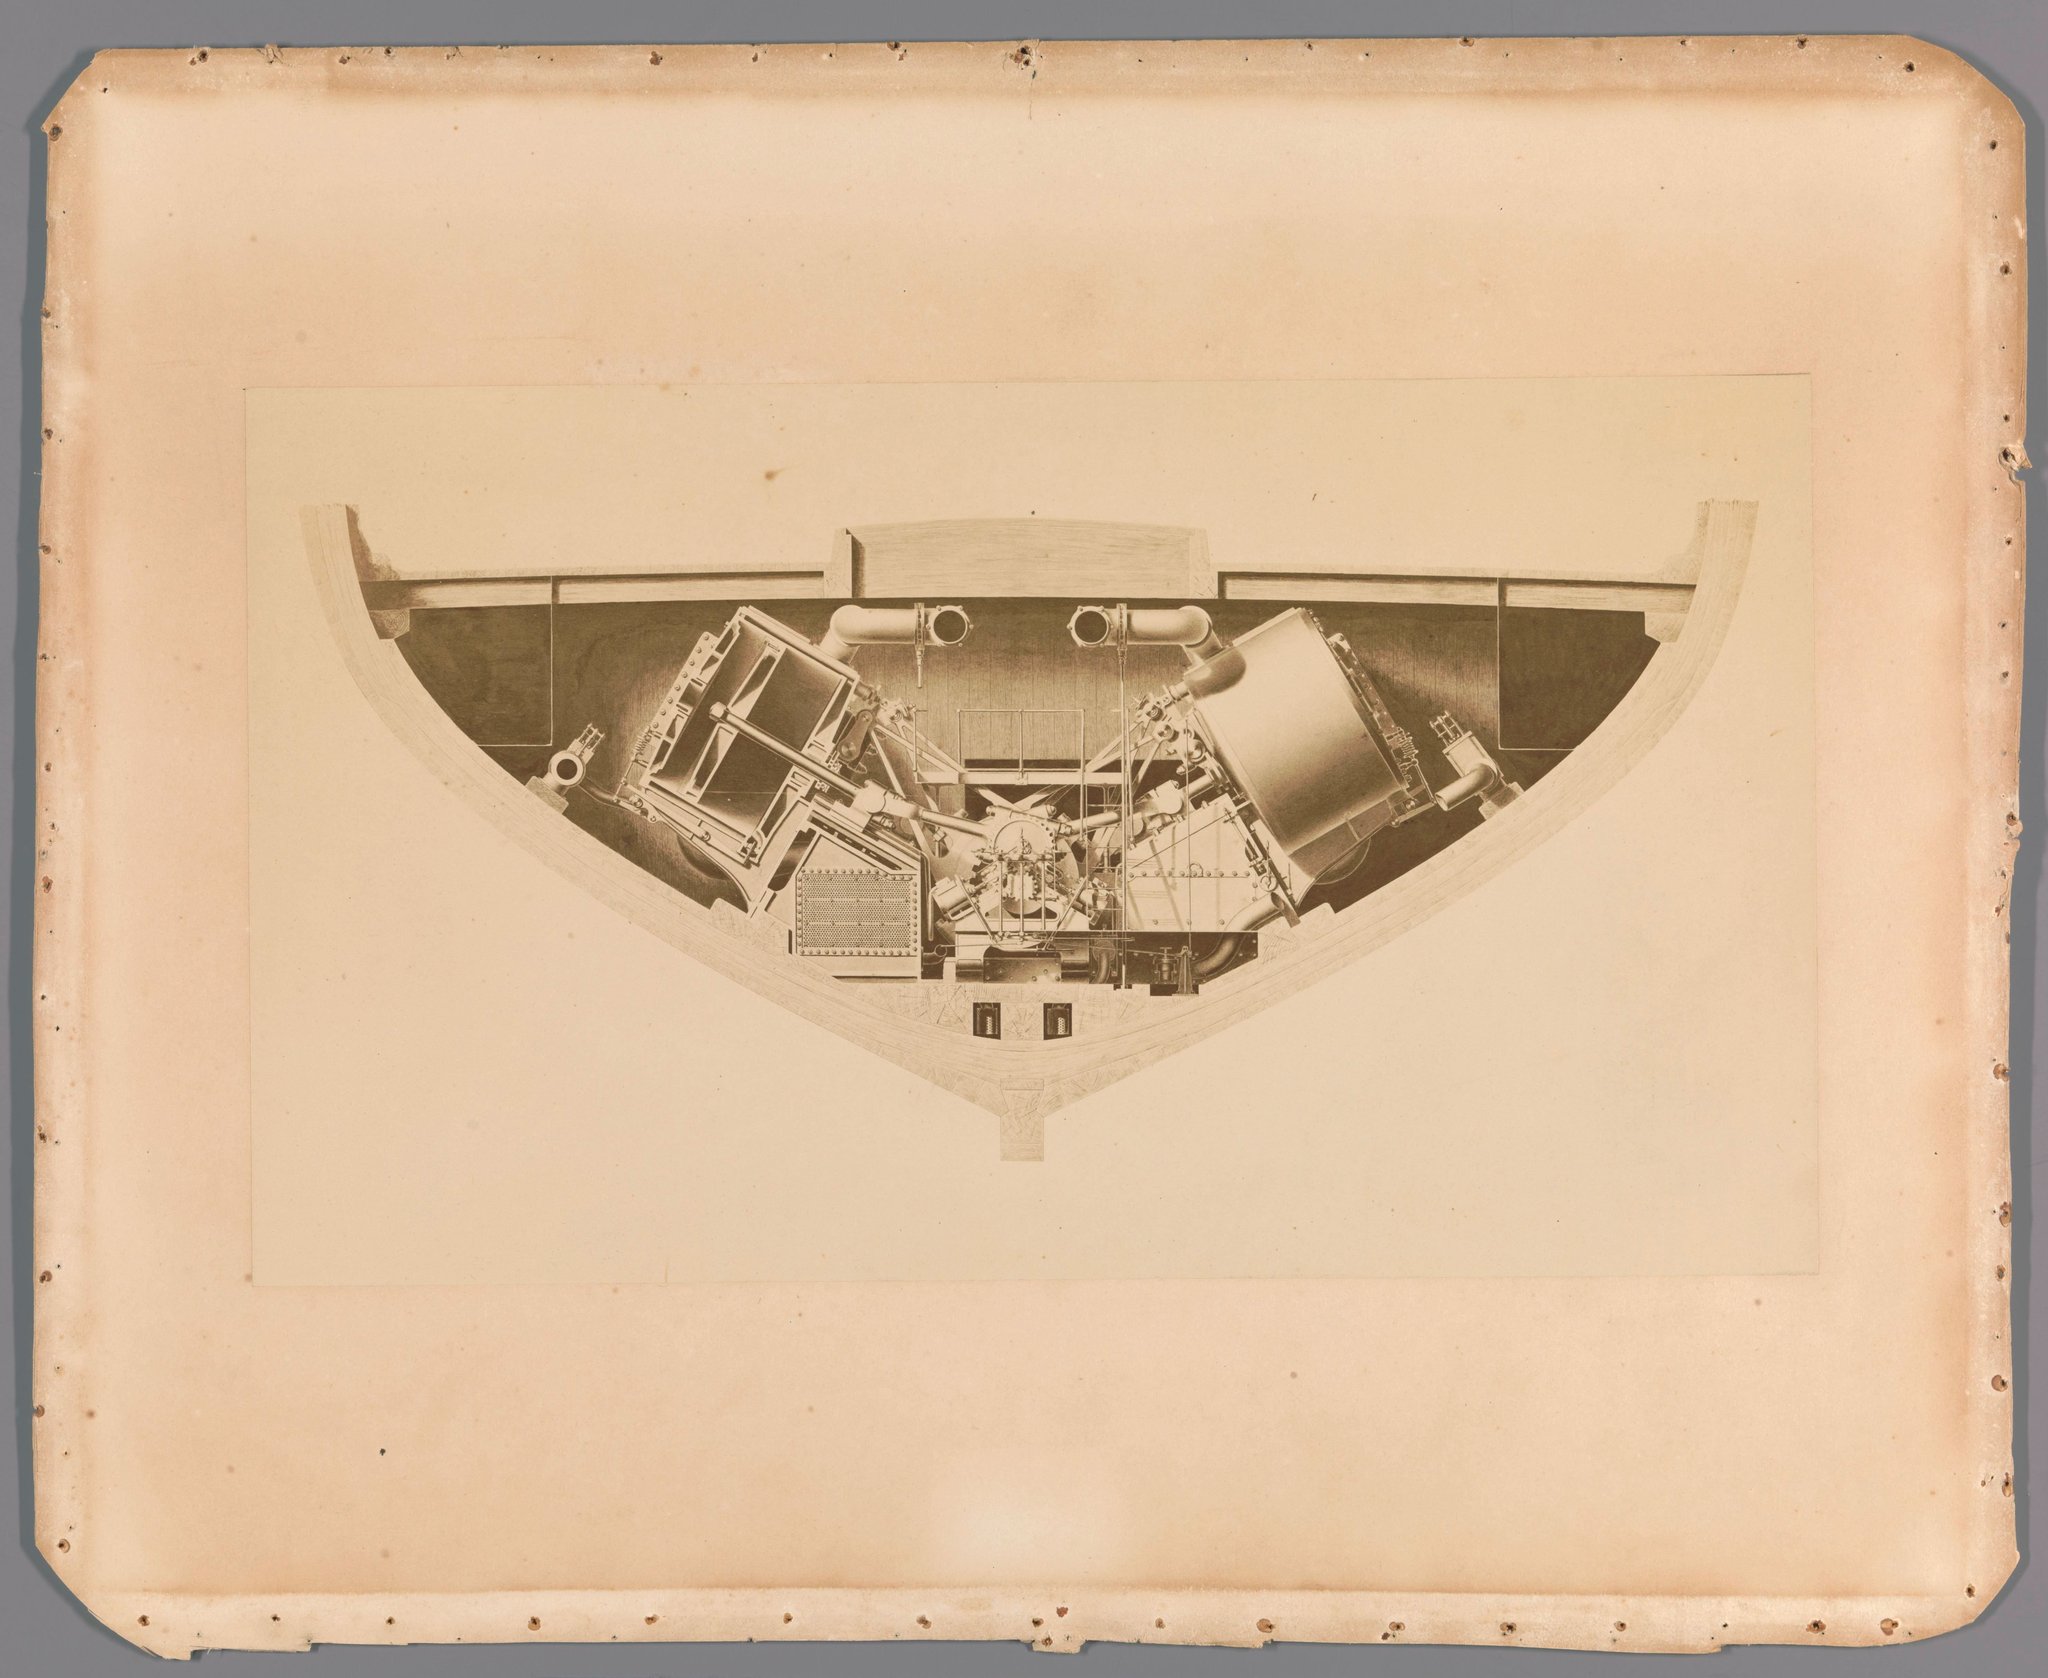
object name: photograph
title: View of a Steam Engine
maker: Anonymous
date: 1870-1880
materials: paper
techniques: photolithography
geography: france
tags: engineer, henry dupuy de lôme, france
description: Afbeelding van een dubbele drie cylinder diagonale stoommachine ontworpen door de Franse ingenieur Henry Dupuy de Lôme, van voren gezien en in een dwarsdoorsnede van een schip geplaatst. De stuurboord machine (links) is in doorsnede afgebeeld.